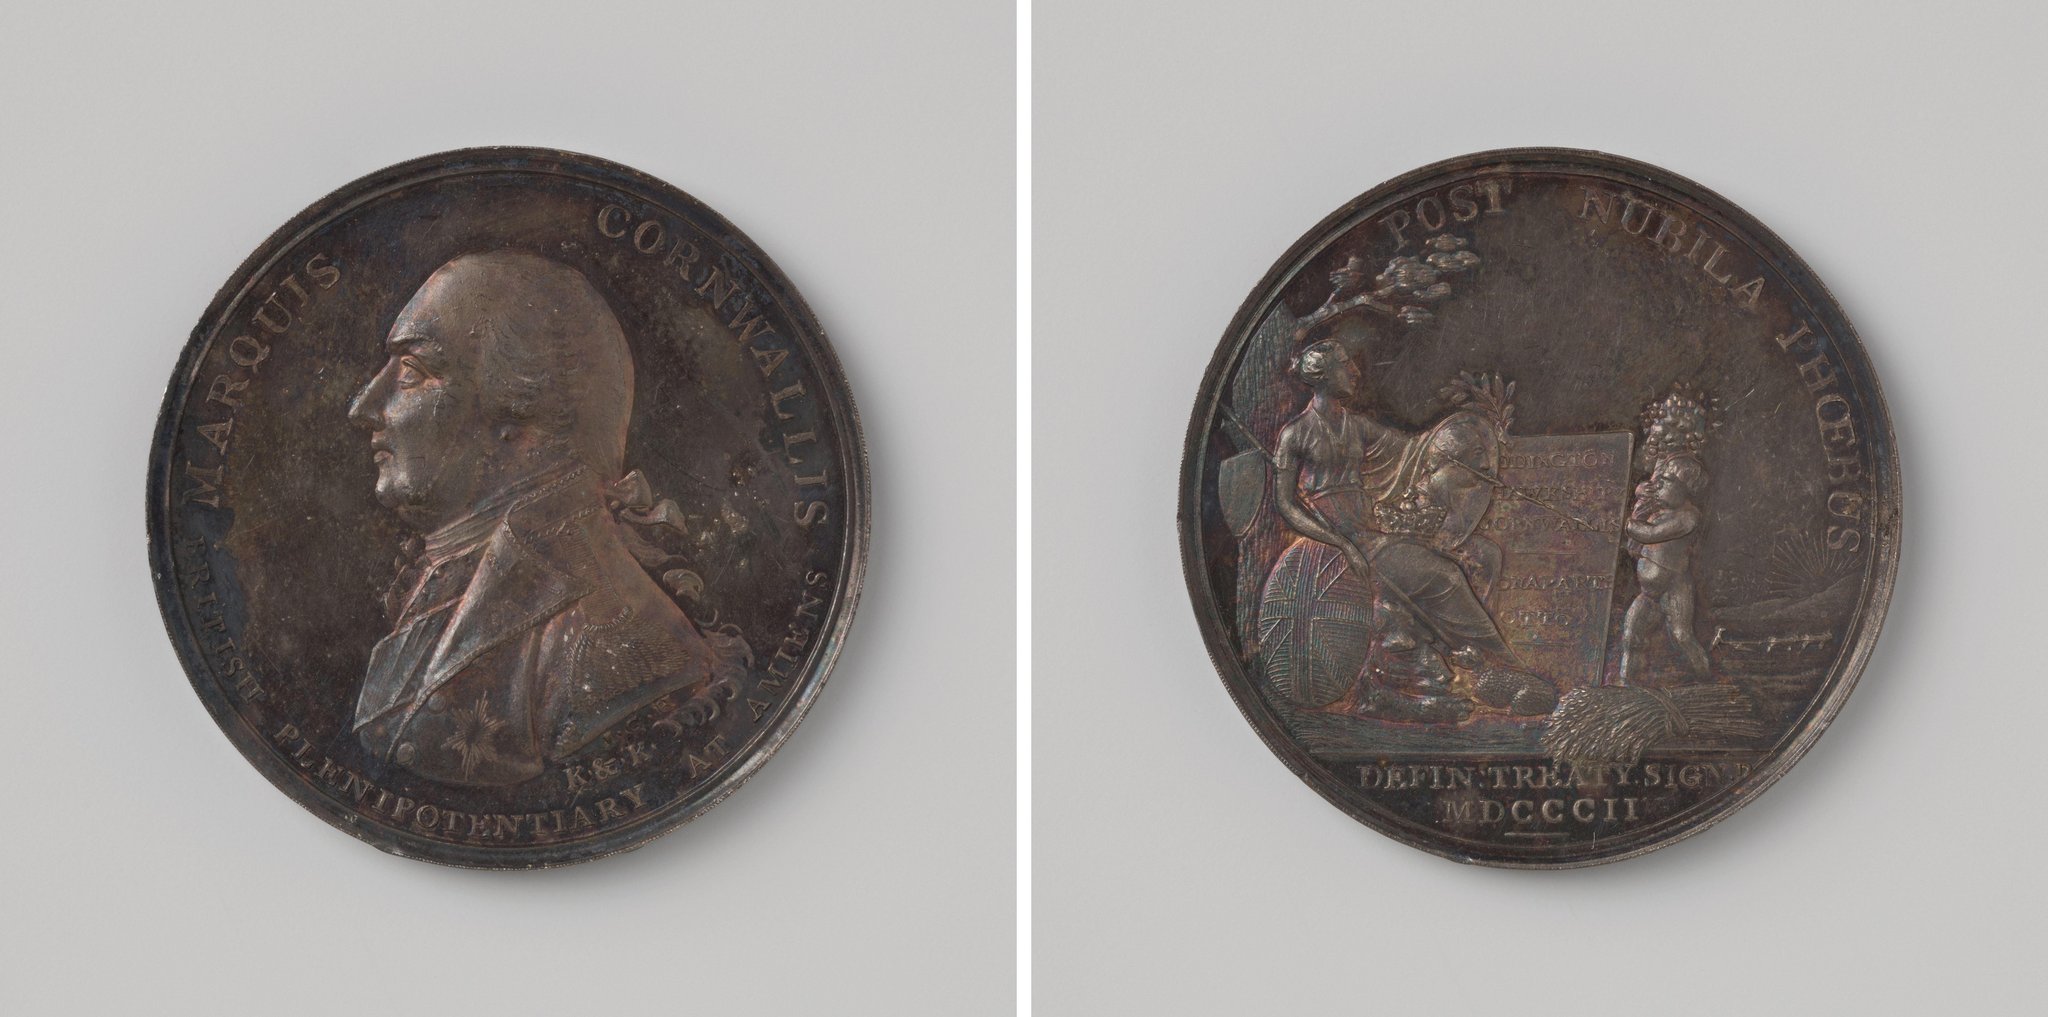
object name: history medal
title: Vrede van Amiens, ter ere van Charles, graaf van Cornwallis, onderhandelaar voor Engeland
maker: john gregory hancock (sr.)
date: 1802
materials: silver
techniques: striking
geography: birmingham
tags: george iii (koning van het verenigd koninkrijk), london, j. otto